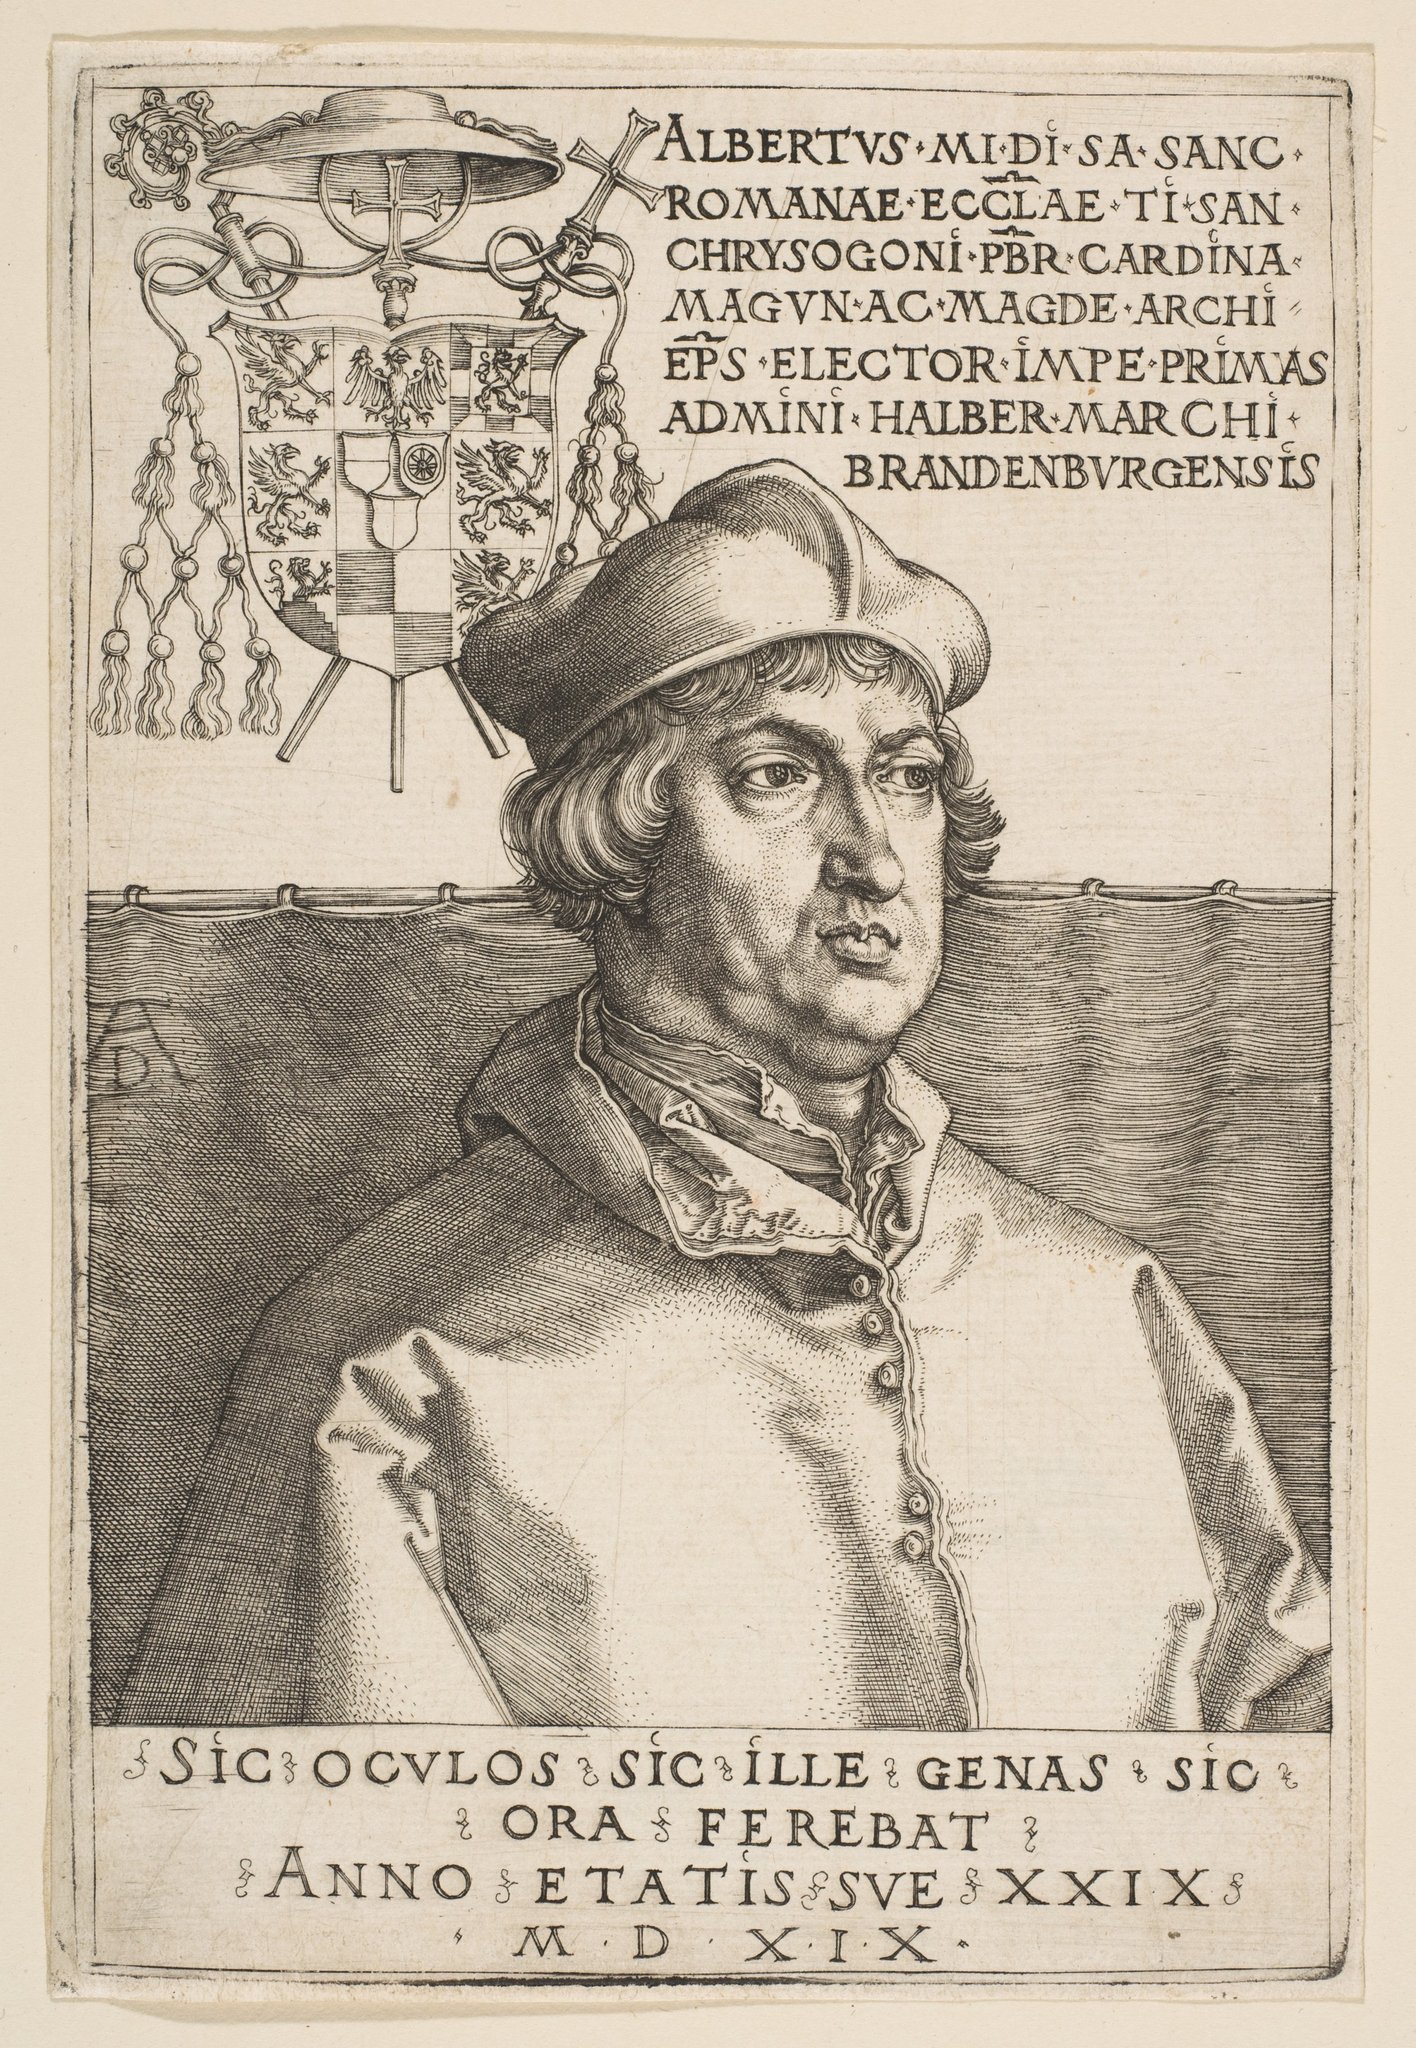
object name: print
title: Cardinal Albrecht of Brandenburg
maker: albrecht dürer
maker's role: artist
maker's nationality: german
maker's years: 1471-1528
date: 1519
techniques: engraving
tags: men,portraits,coat of arms